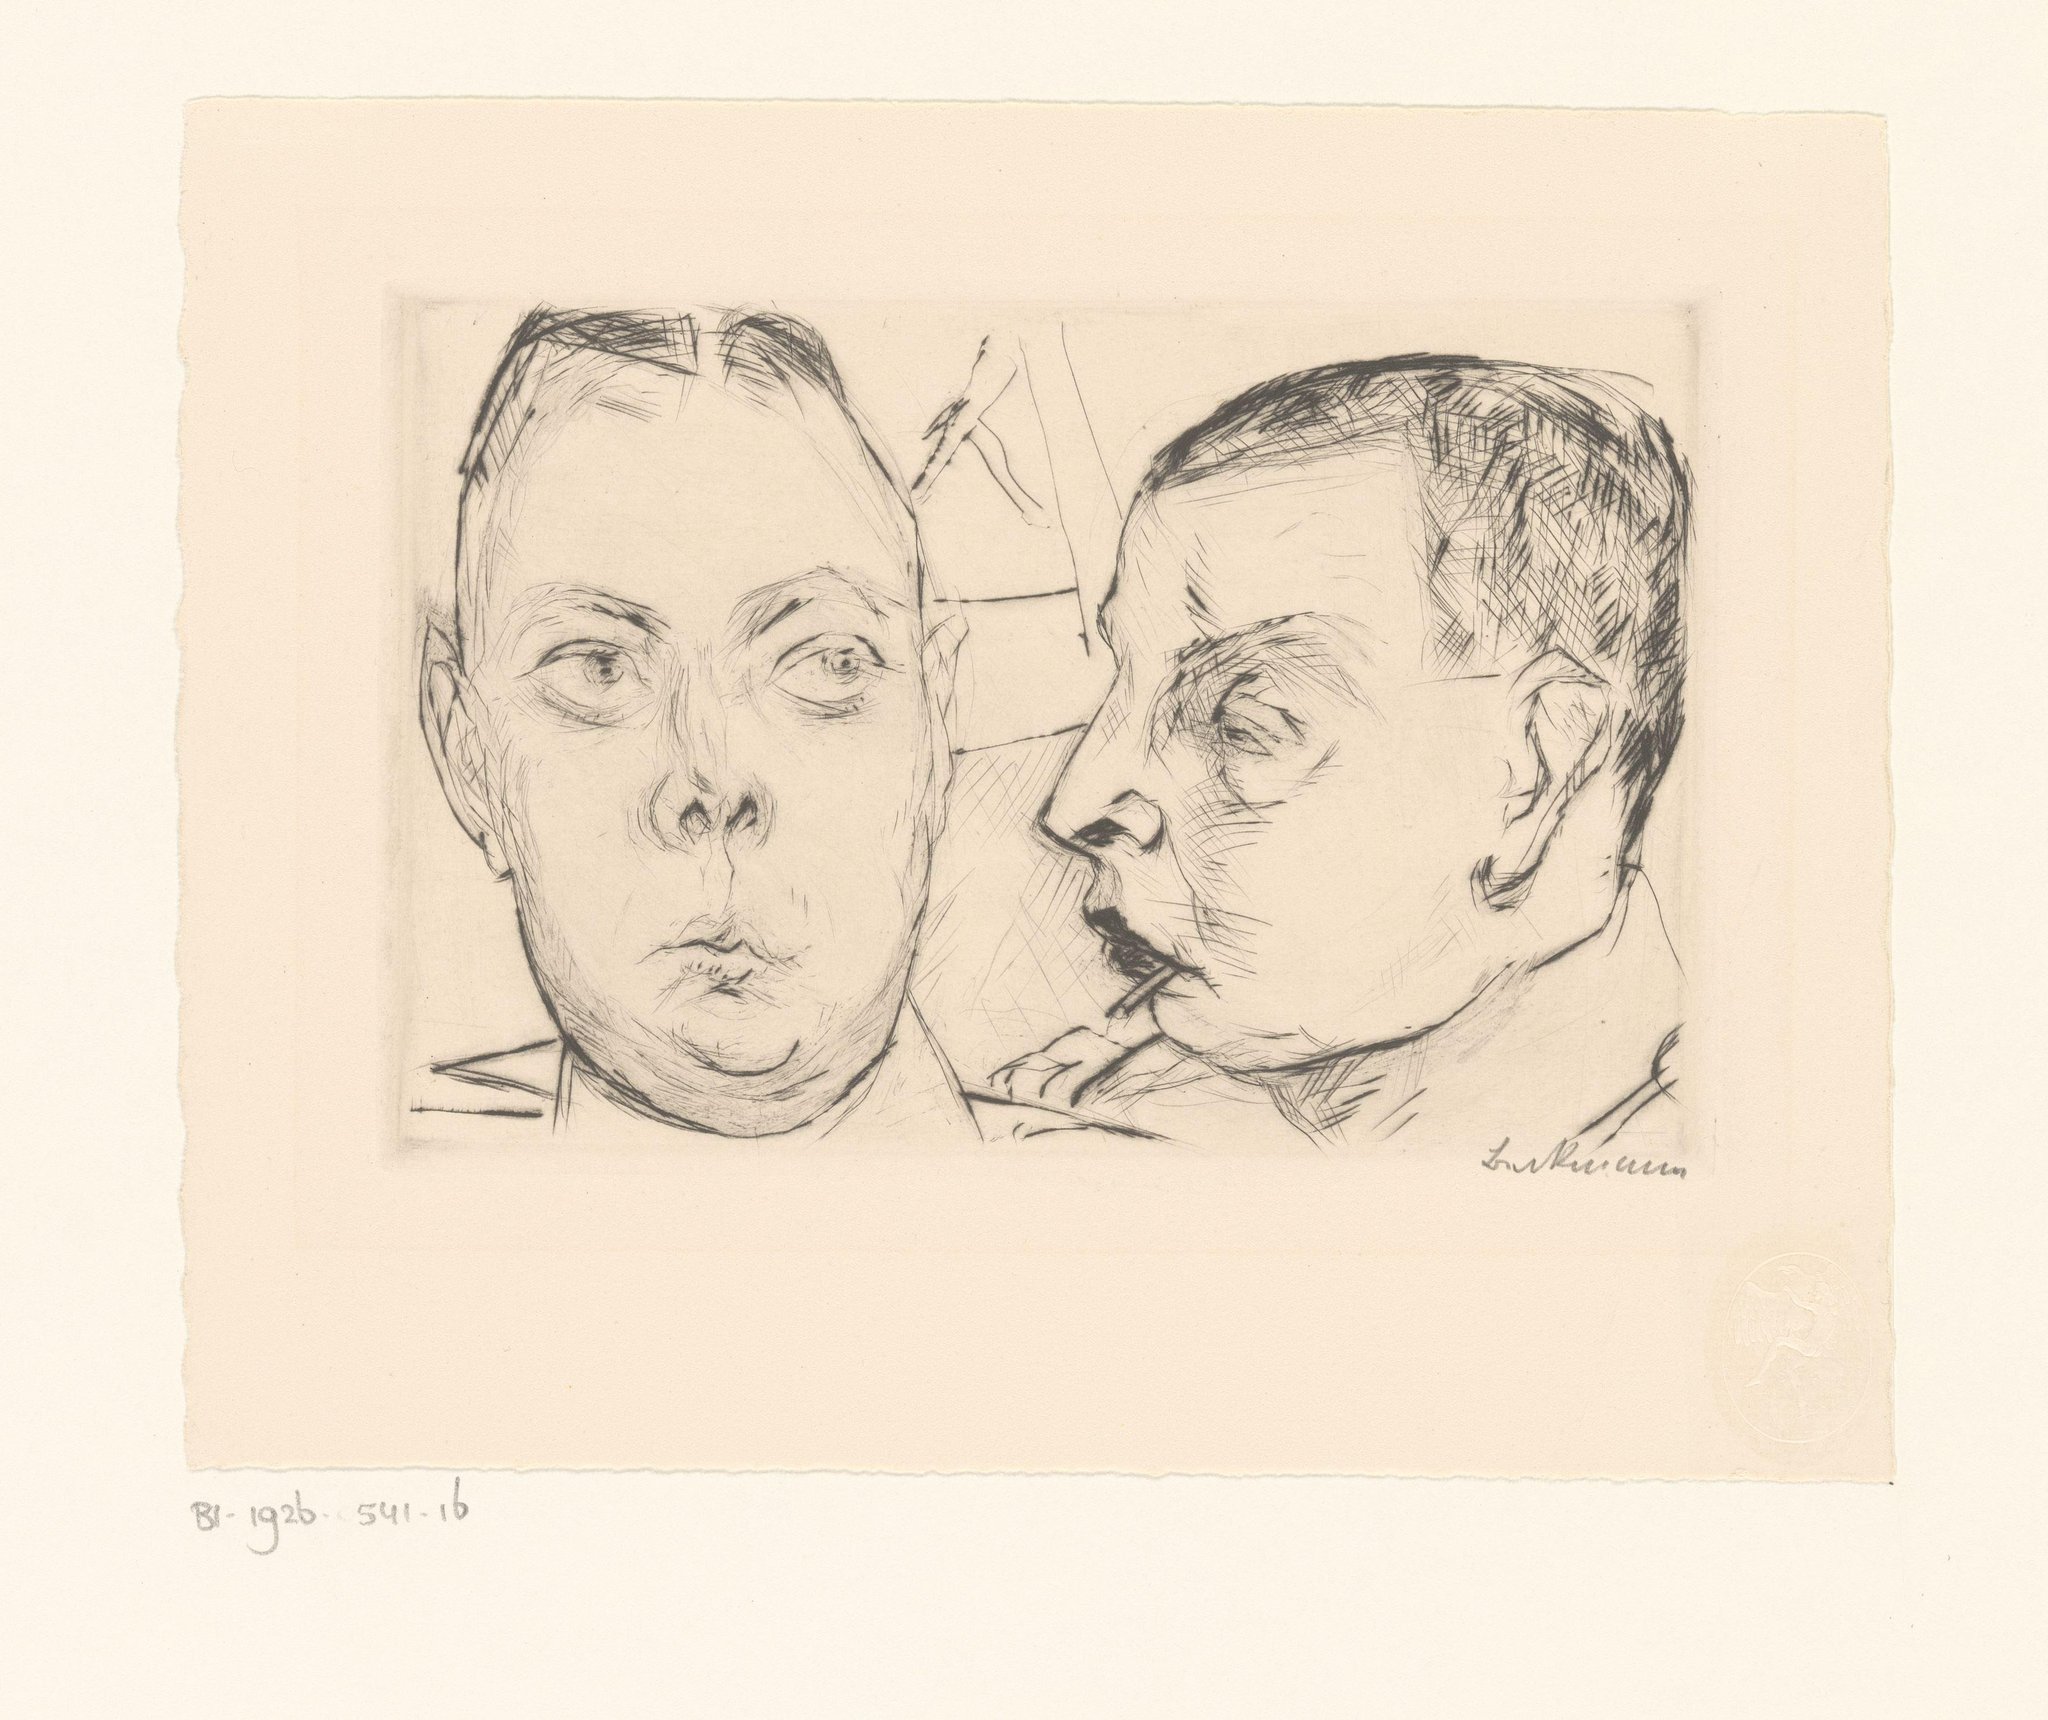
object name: print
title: Portretten van twee onbekende officieren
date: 1915-1919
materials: paper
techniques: drypoint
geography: munich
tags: officer, anonymous historical persons portrayed in a double portrait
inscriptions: collector's mark: Lugt 5629, collector's mark: Lugt 2166